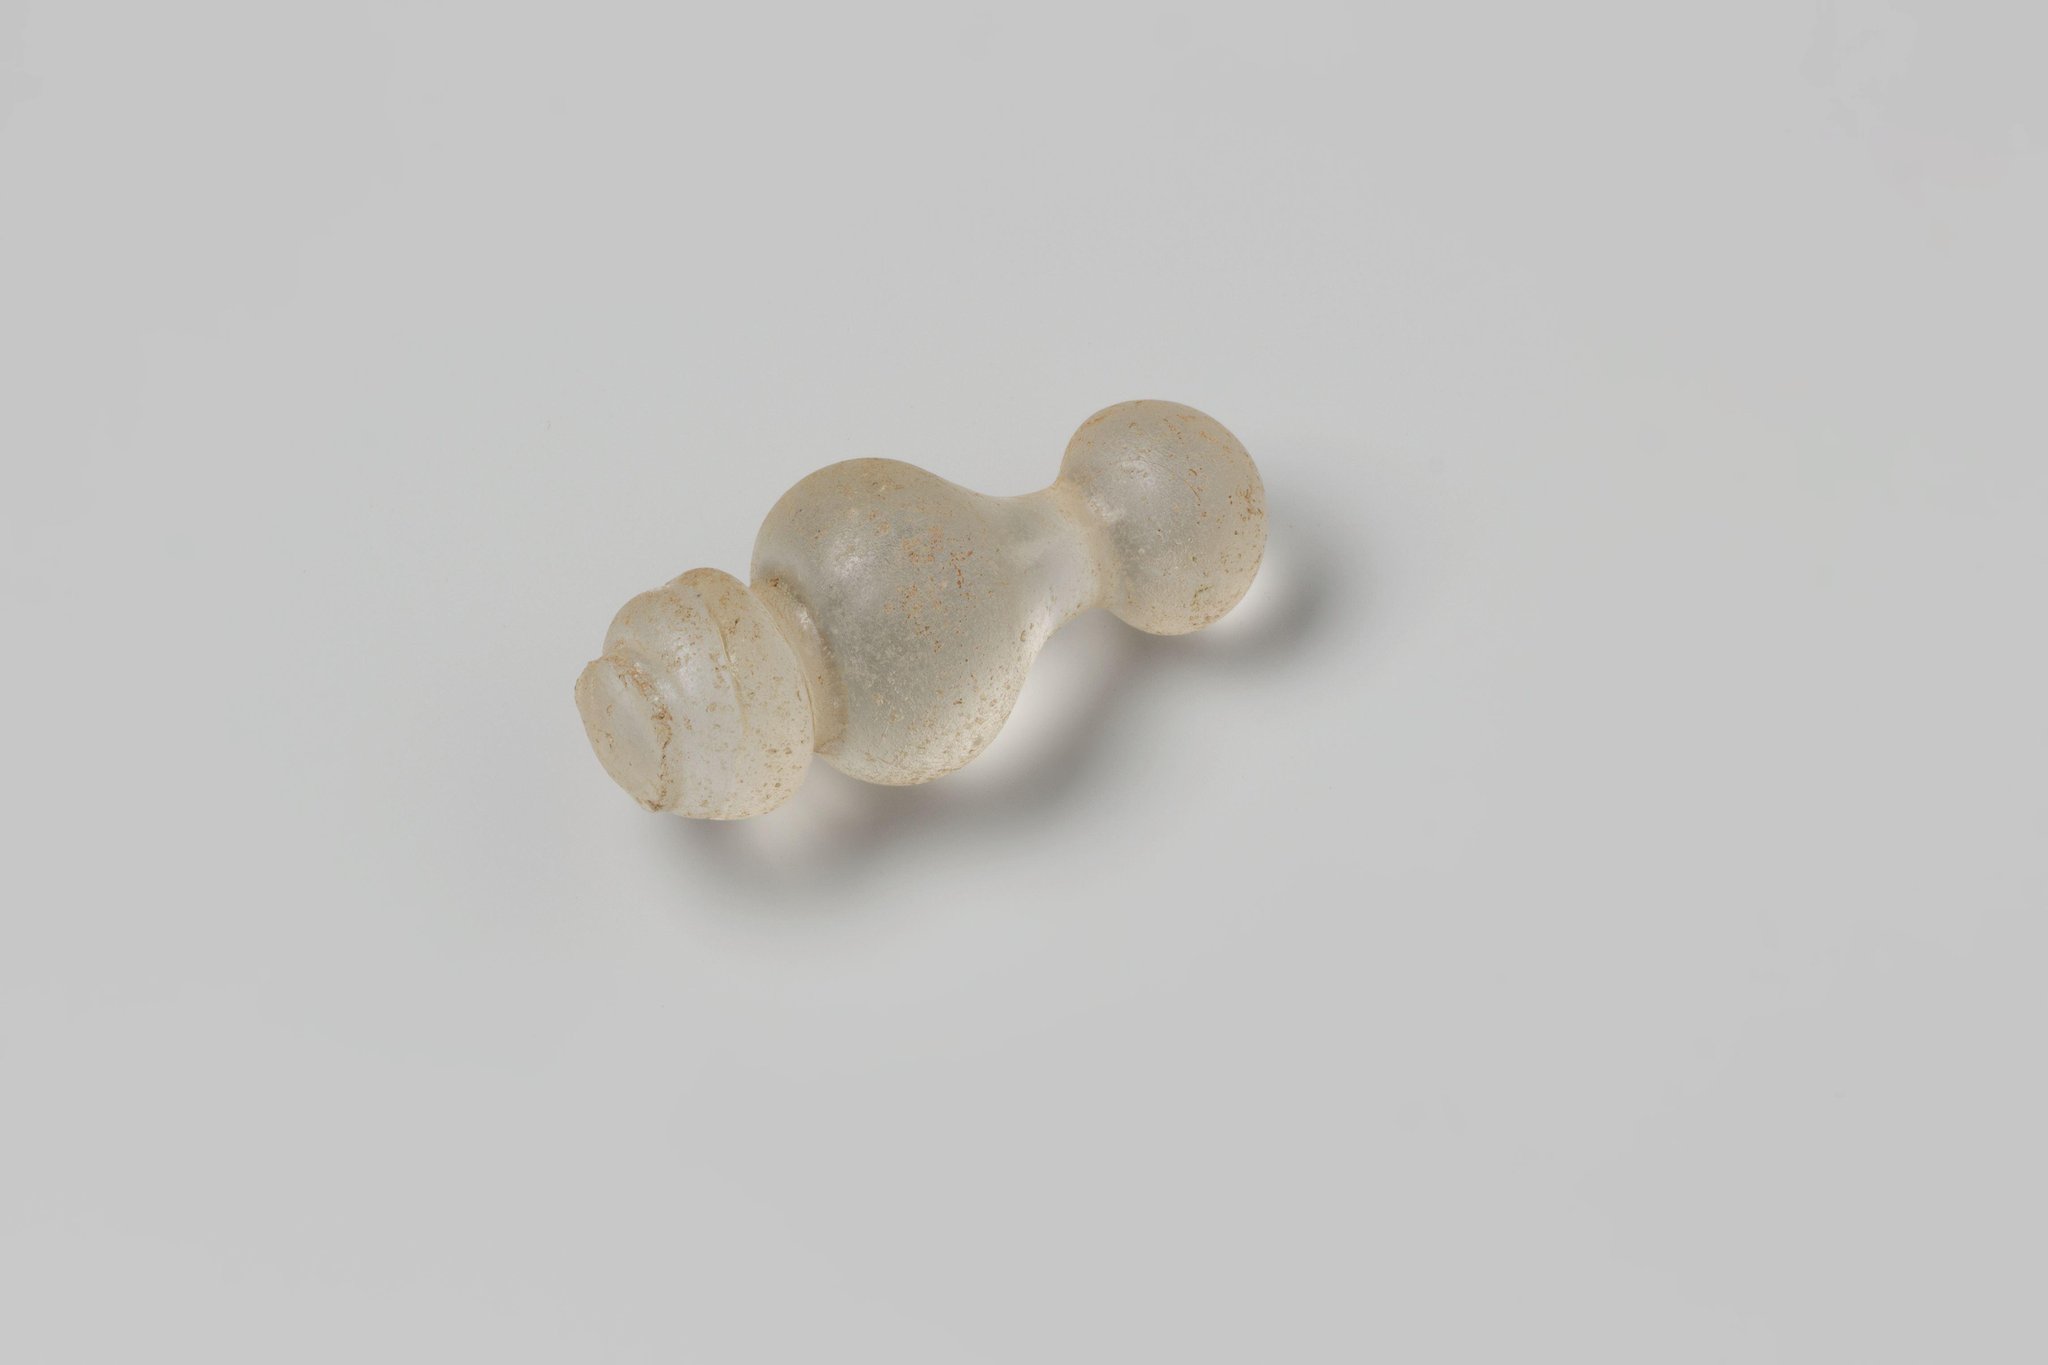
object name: fioel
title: Fioel van vaatwerk uit het wrak van de Oost-Indiëvaarder Hollandia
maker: Anonymous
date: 1700-1743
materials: glass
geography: netherlands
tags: verenigde oostindische compagnie, hollandia (schip), annet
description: Vessel part, finial; baluster with spherical knop, broken off underneath.